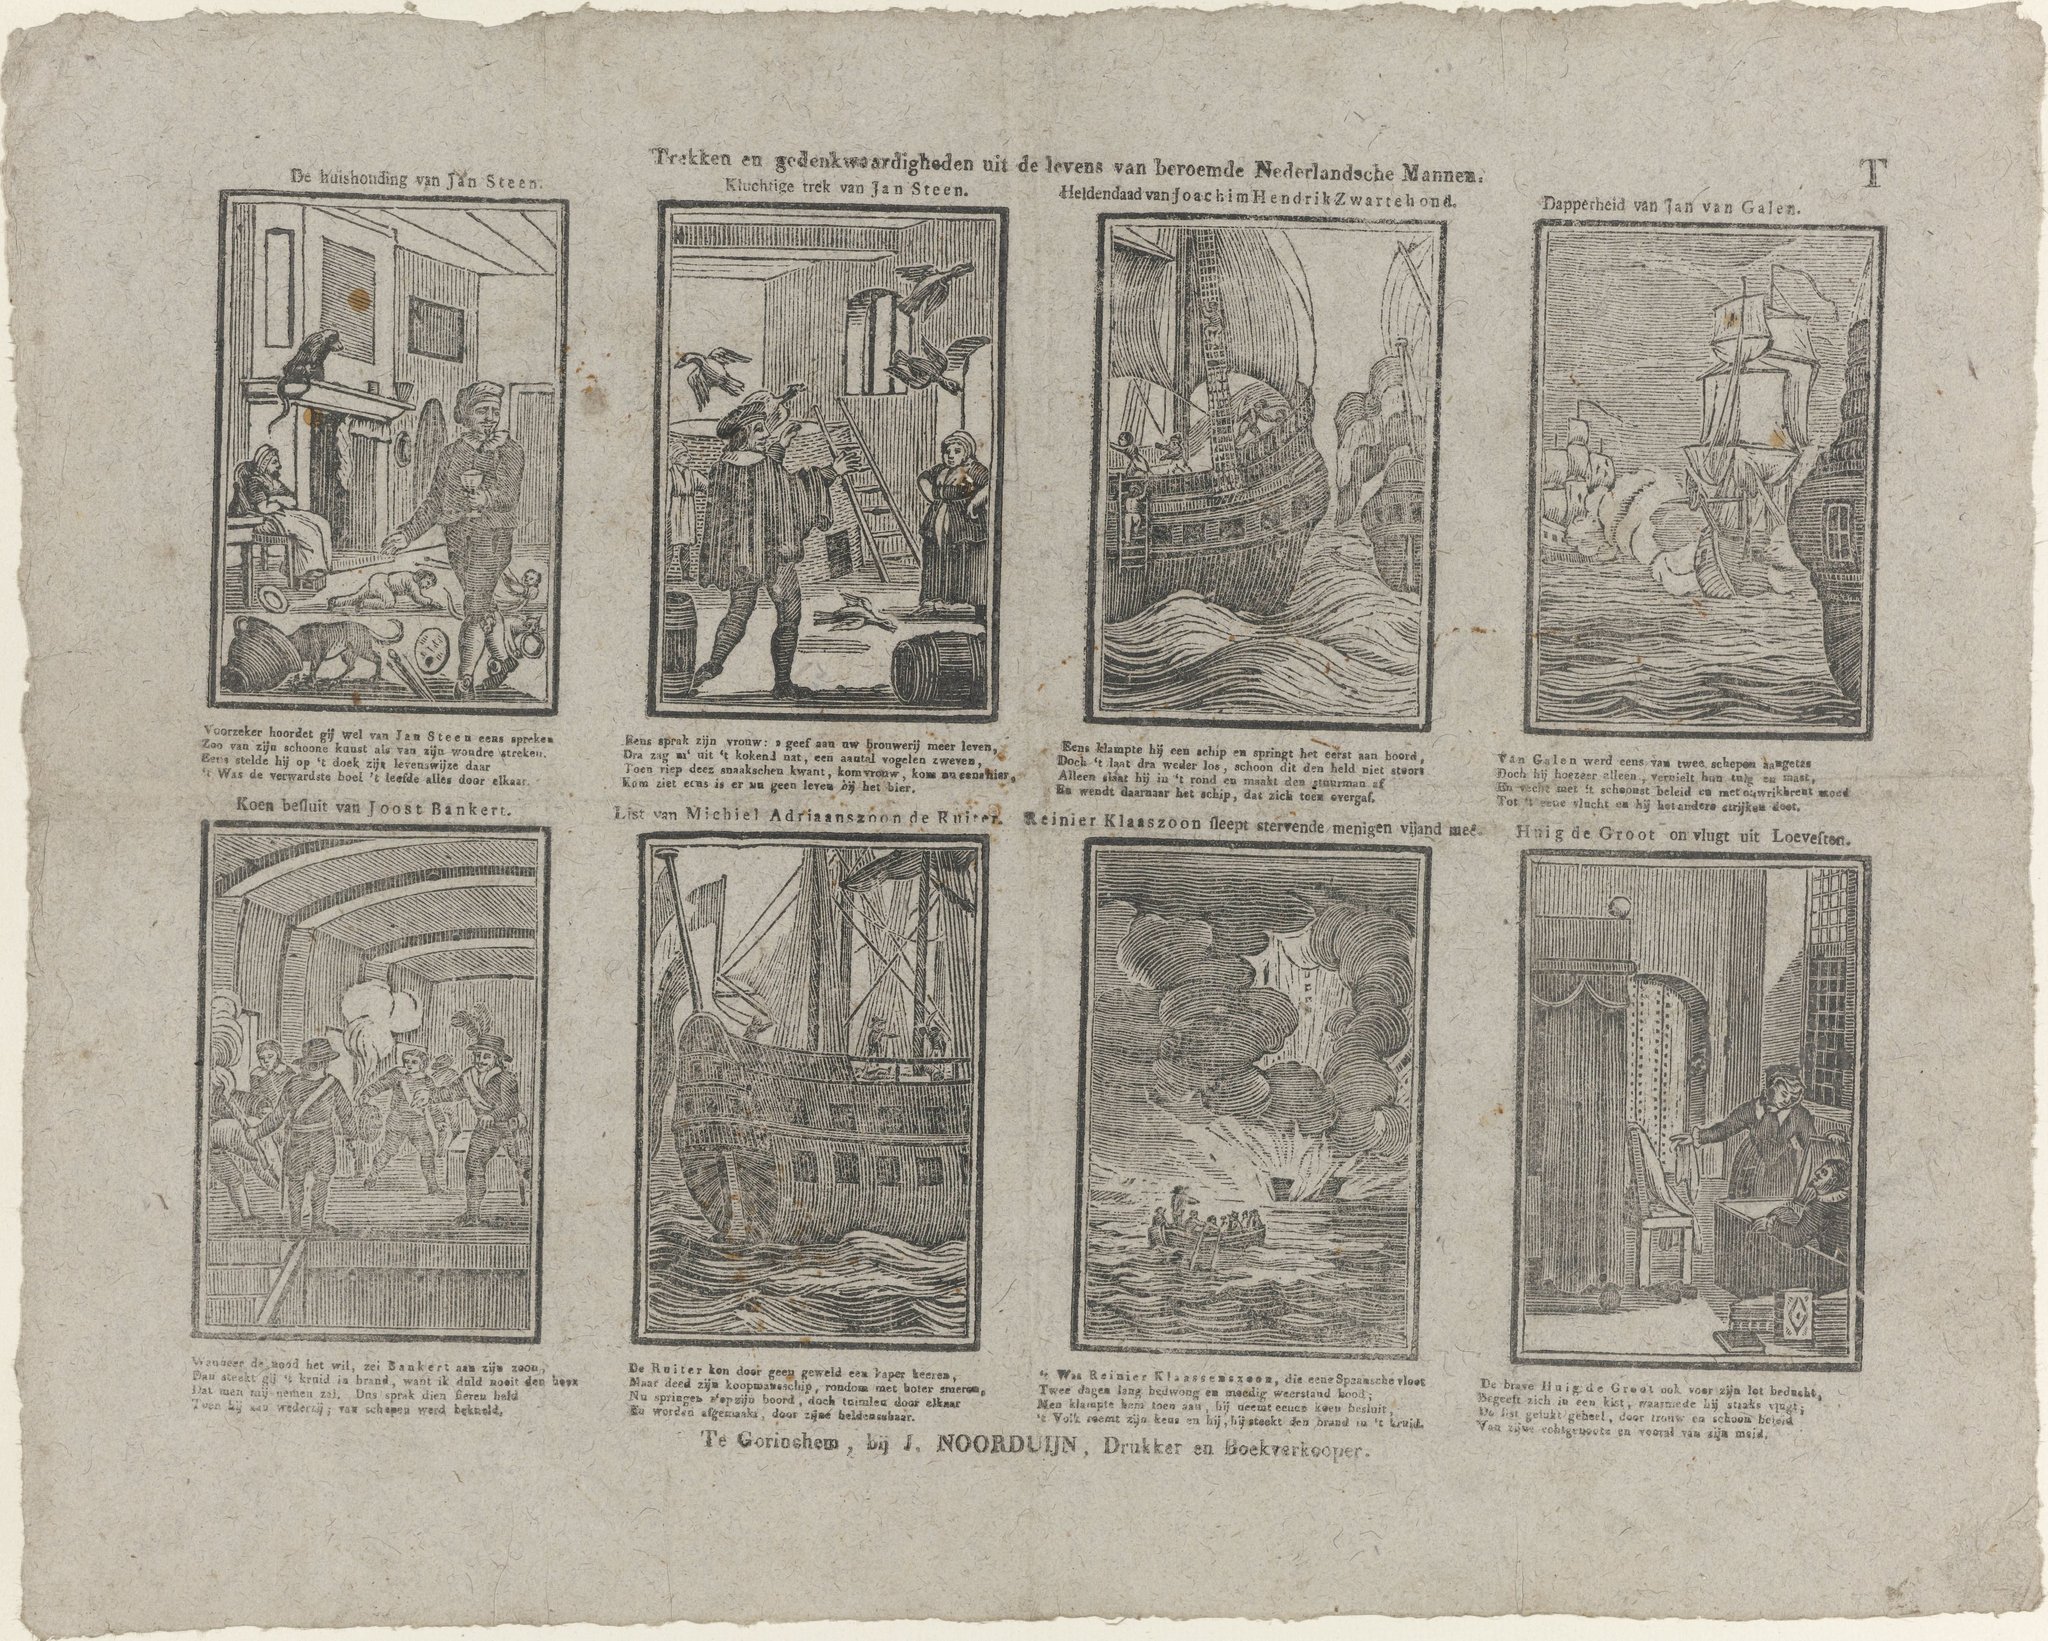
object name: print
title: Trekken en gedenkwaardigheden uit de levens van beroemde Nederlandsche mannen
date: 1819-1840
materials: paper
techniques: letterpress printing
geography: gorinchem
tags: delft, hugo de groot, leiden, painter, print maker, jan havicksz. steen, flushing, michiel adriaenszoon de ruyter, amsterdam, essen, a perfect shambles (dutch: 'huishouden van jan steen'), classical mythology and ancient history, loevestein castle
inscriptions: collector's mark: Lugt 2760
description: Blad met 8 voorstellingen uit het leven van beroemde Nederlandse mannen, onder wie Jan Steen, Jan van Galen, Michiel Adriaenszoon de Ruyter, Joachim Hendrik Swartenhondt en Hugo de Groot. Onder elke afbeelding een vierregelig vers en boven elke afbeelding een titel. Gemerkt rechtsboven: T.